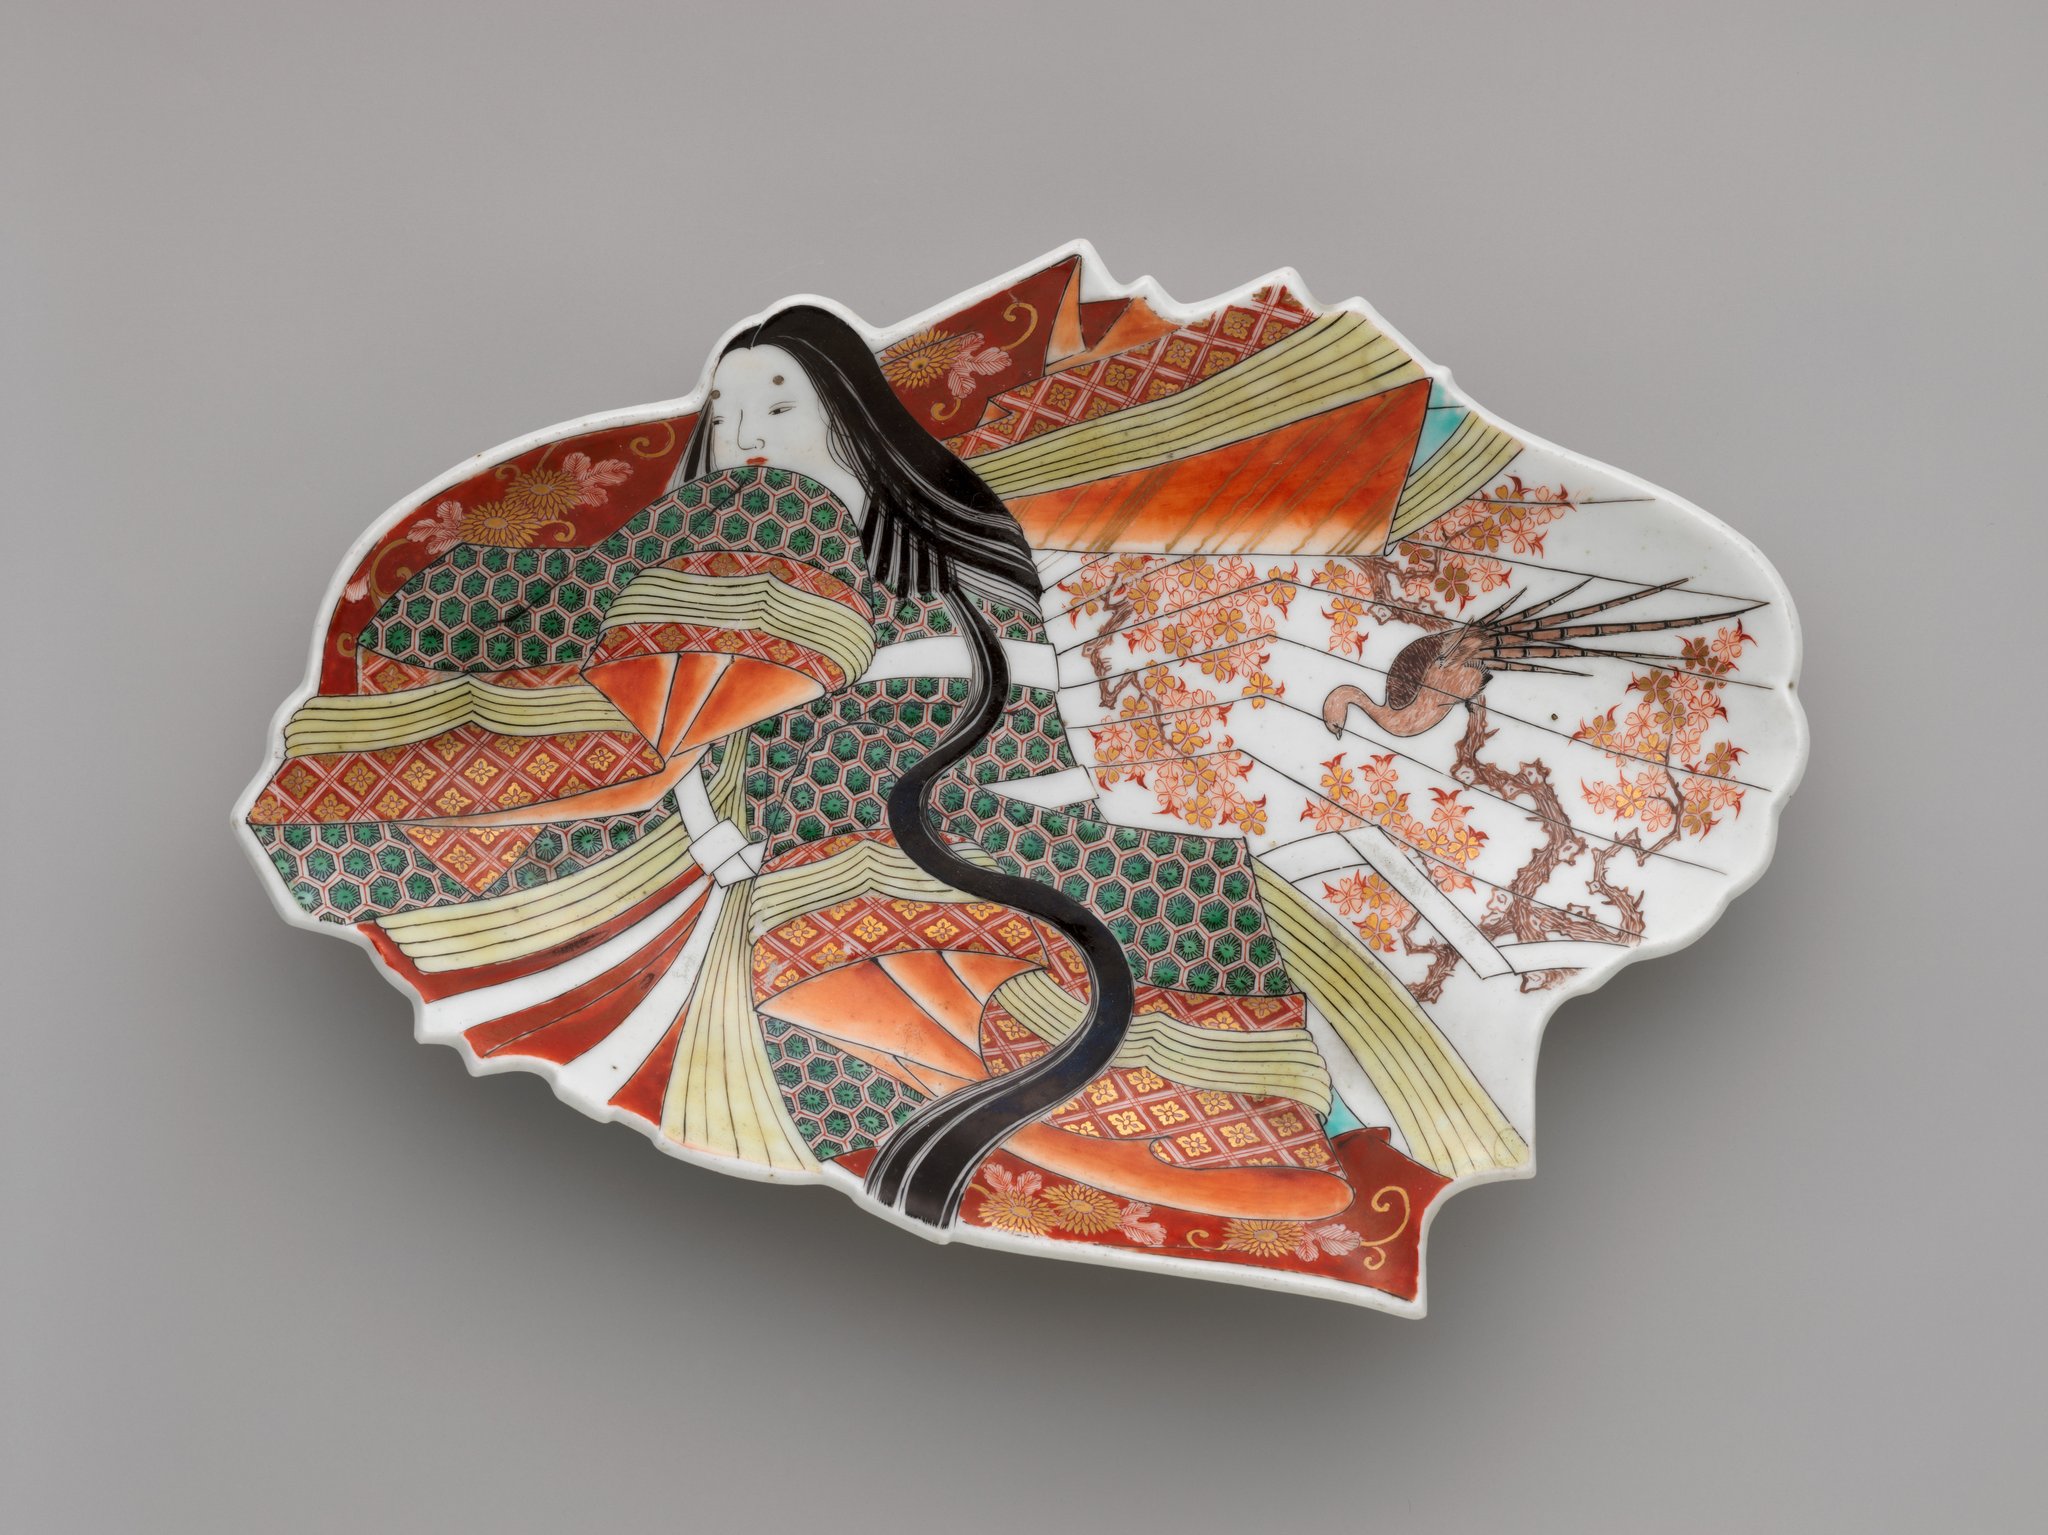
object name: dish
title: Dish in Shape of Japanese Court Woman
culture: japanese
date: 1780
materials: enamel, glaze, porcelain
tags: birds,women